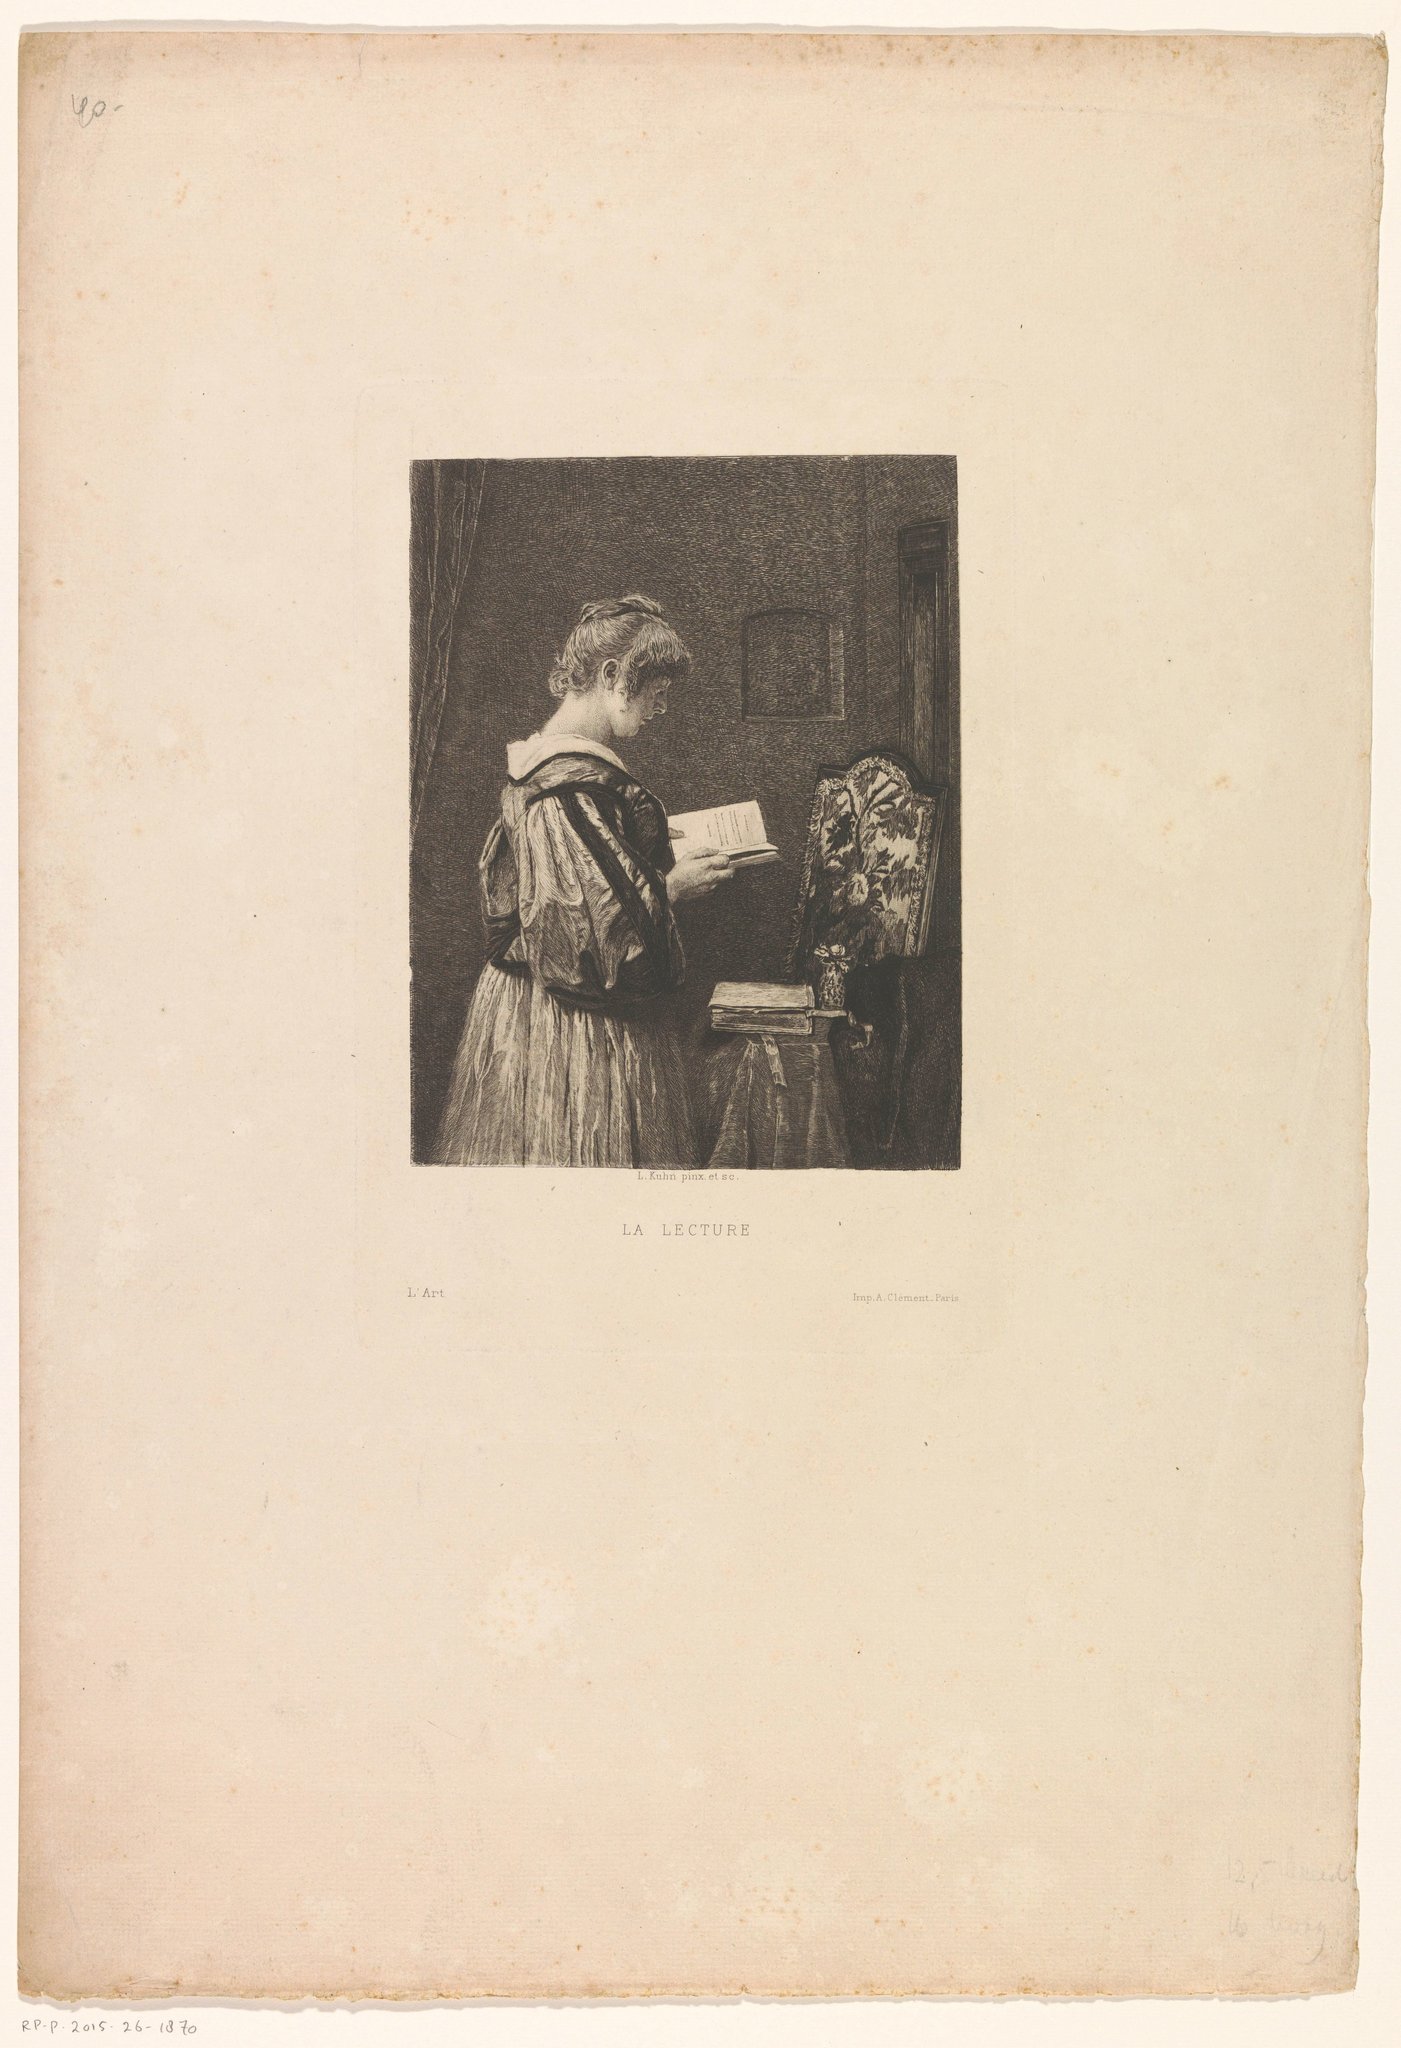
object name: print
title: La lecture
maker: ludwig kühn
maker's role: artist, painter, print maker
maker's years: 1859-1936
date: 1888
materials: paper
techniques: etching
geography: nuremberg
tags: reading, book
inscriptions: collector's mark: Lugt 2228, collector's mark: Lugt 4779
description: Prent afkomstig uit: L'art: revue hebdomadaire illustrée, 1888.